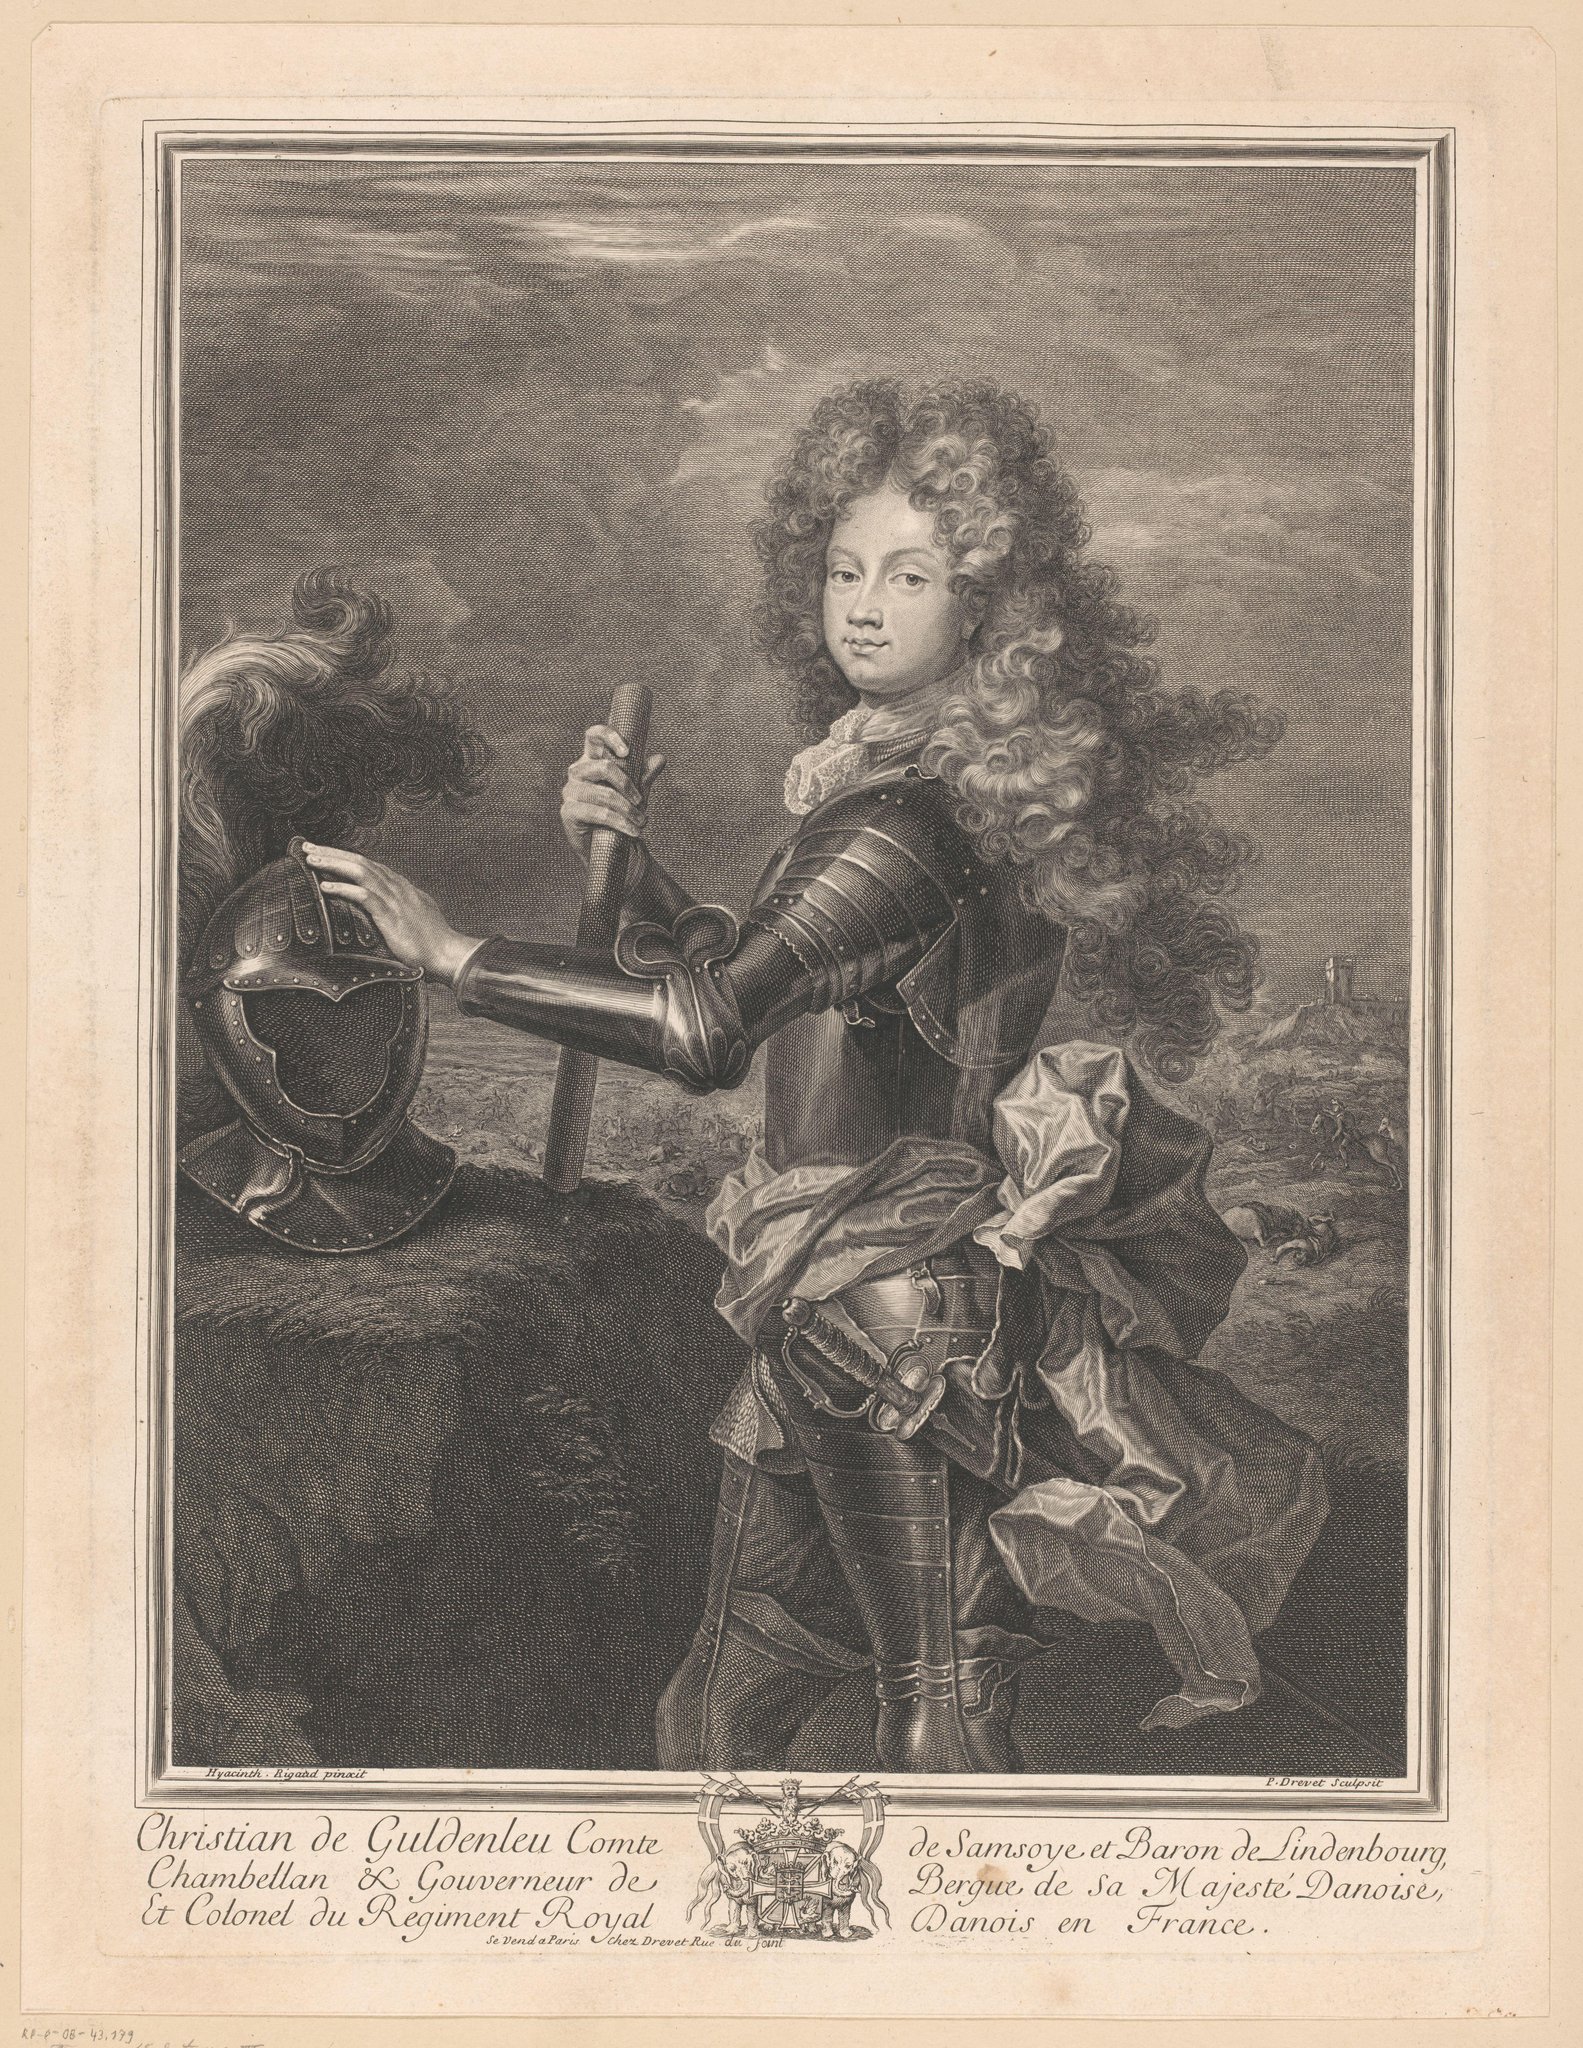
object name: print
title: Christian de Guldenleu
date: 1673-1738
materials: paper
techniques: engraving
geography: paris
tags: armour, historical persons, armorial bearing, heraldry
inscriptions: collector's mark: Lugt 240